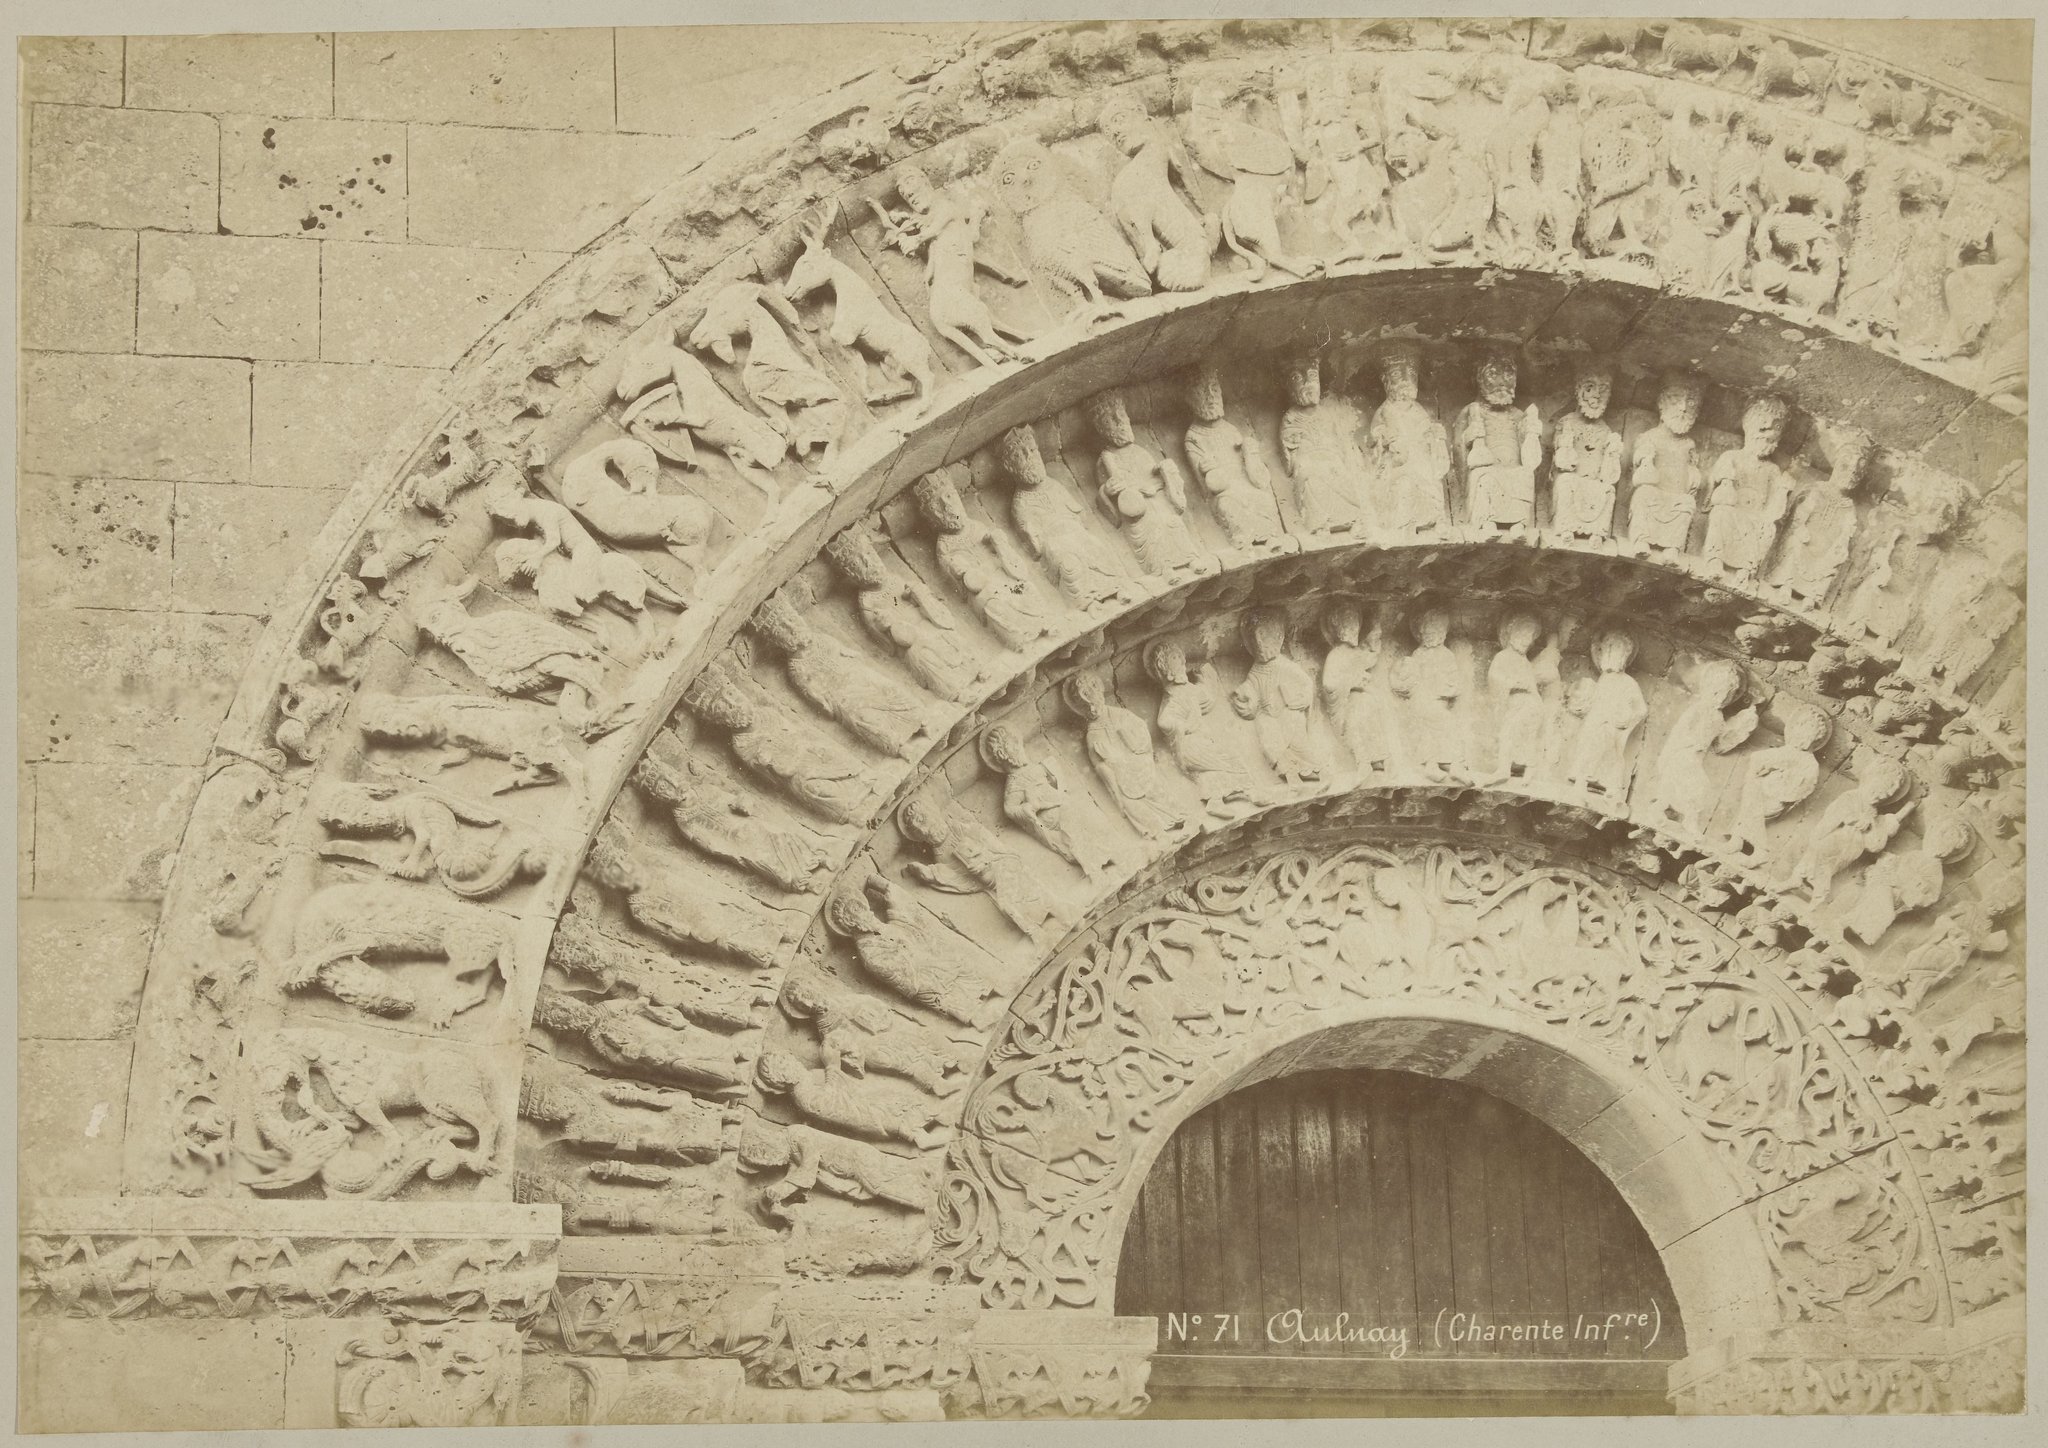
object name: photograph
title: Beeldhouwwerken boven een portaal van de kerk van Saint-Pierre d'Aulnay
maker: paul robert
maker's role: fotograaf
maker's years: 1865-1905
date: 1890-1900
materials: cardboard, paper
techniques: albumen print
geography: aulnay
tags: parts of church exterior and annexes: portal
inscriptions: number: ‘No 71’